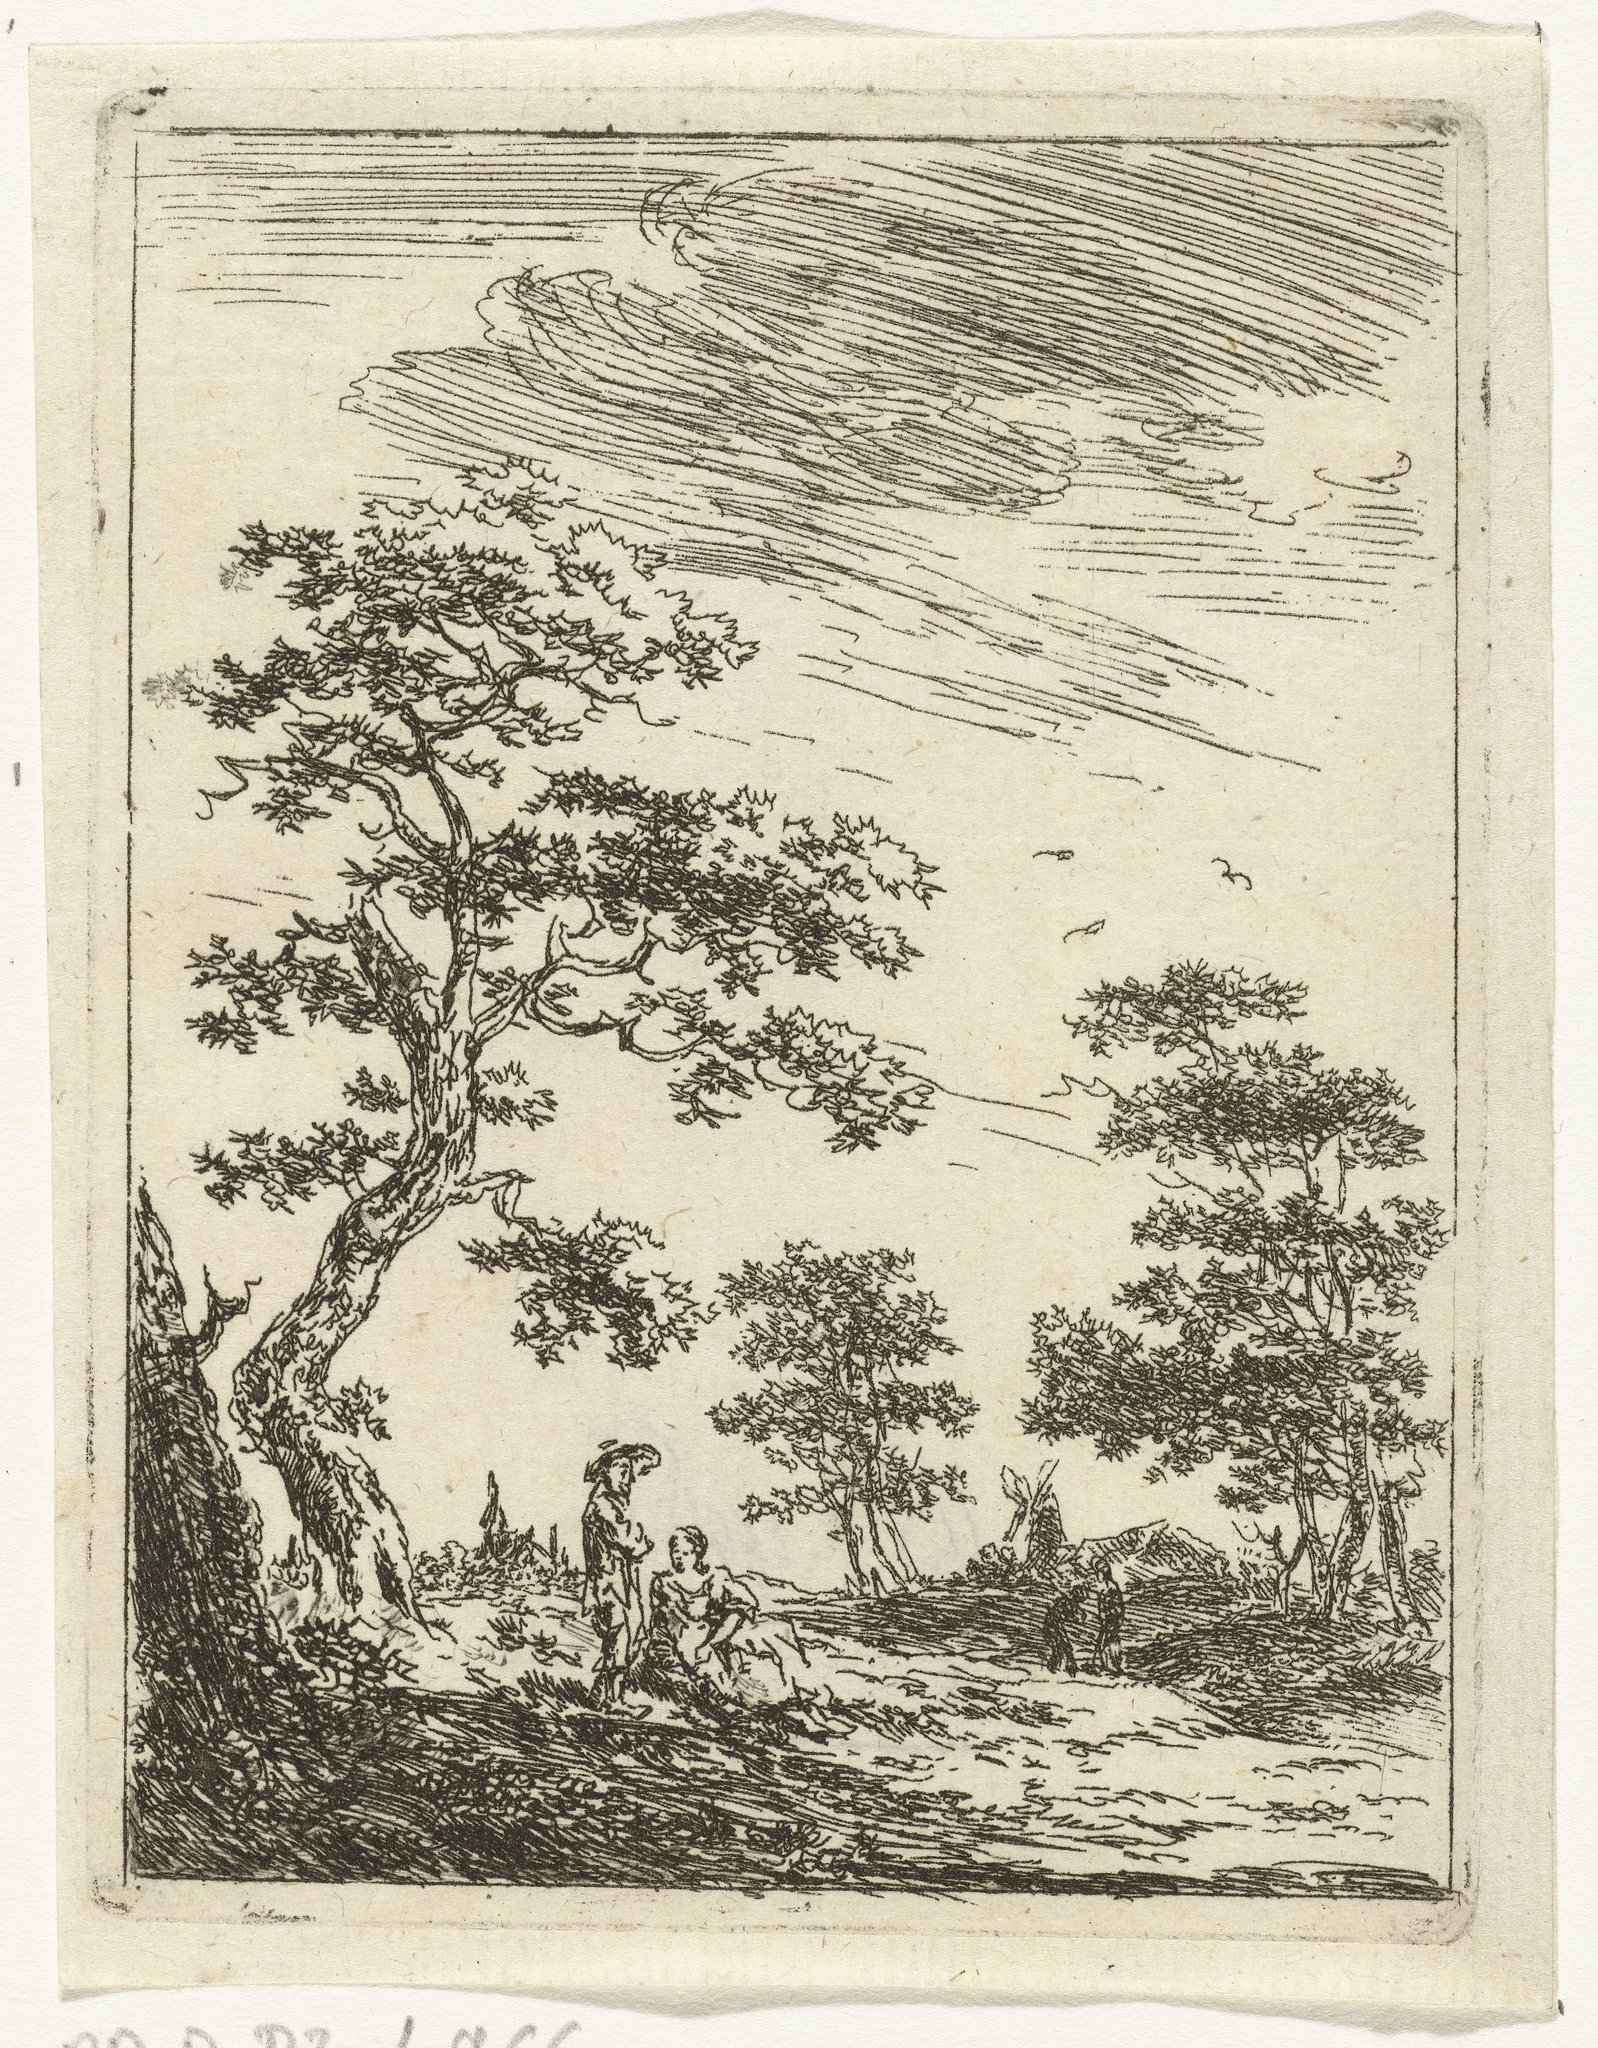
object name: print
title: Paar onder boom in landschap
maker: hermanus van brussel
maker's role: draughtsman, print maker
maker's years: 1763-1815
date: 1800-1815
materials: paper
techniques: drypoint, etching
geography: netherlands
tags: landscapes in the temperate zone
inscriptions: collector's mark: Lugt 2228